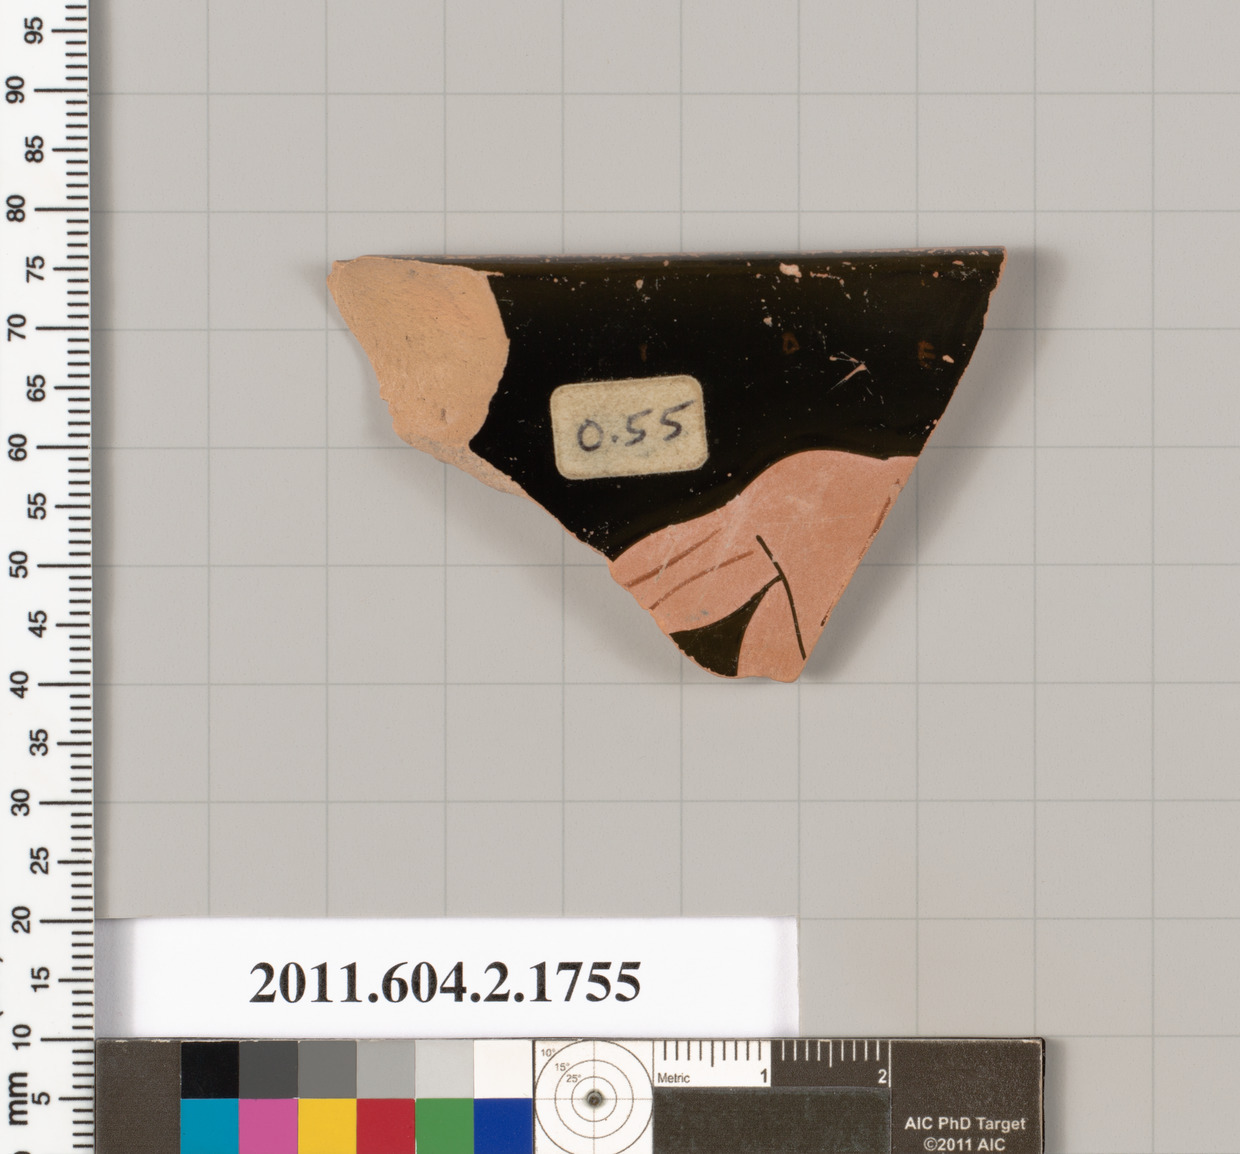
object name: skyphos fragment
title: Terracotta rim fragment of a skyphos (deep drinking cup)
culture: greek, attic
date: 480-470 BCE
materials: terracotta